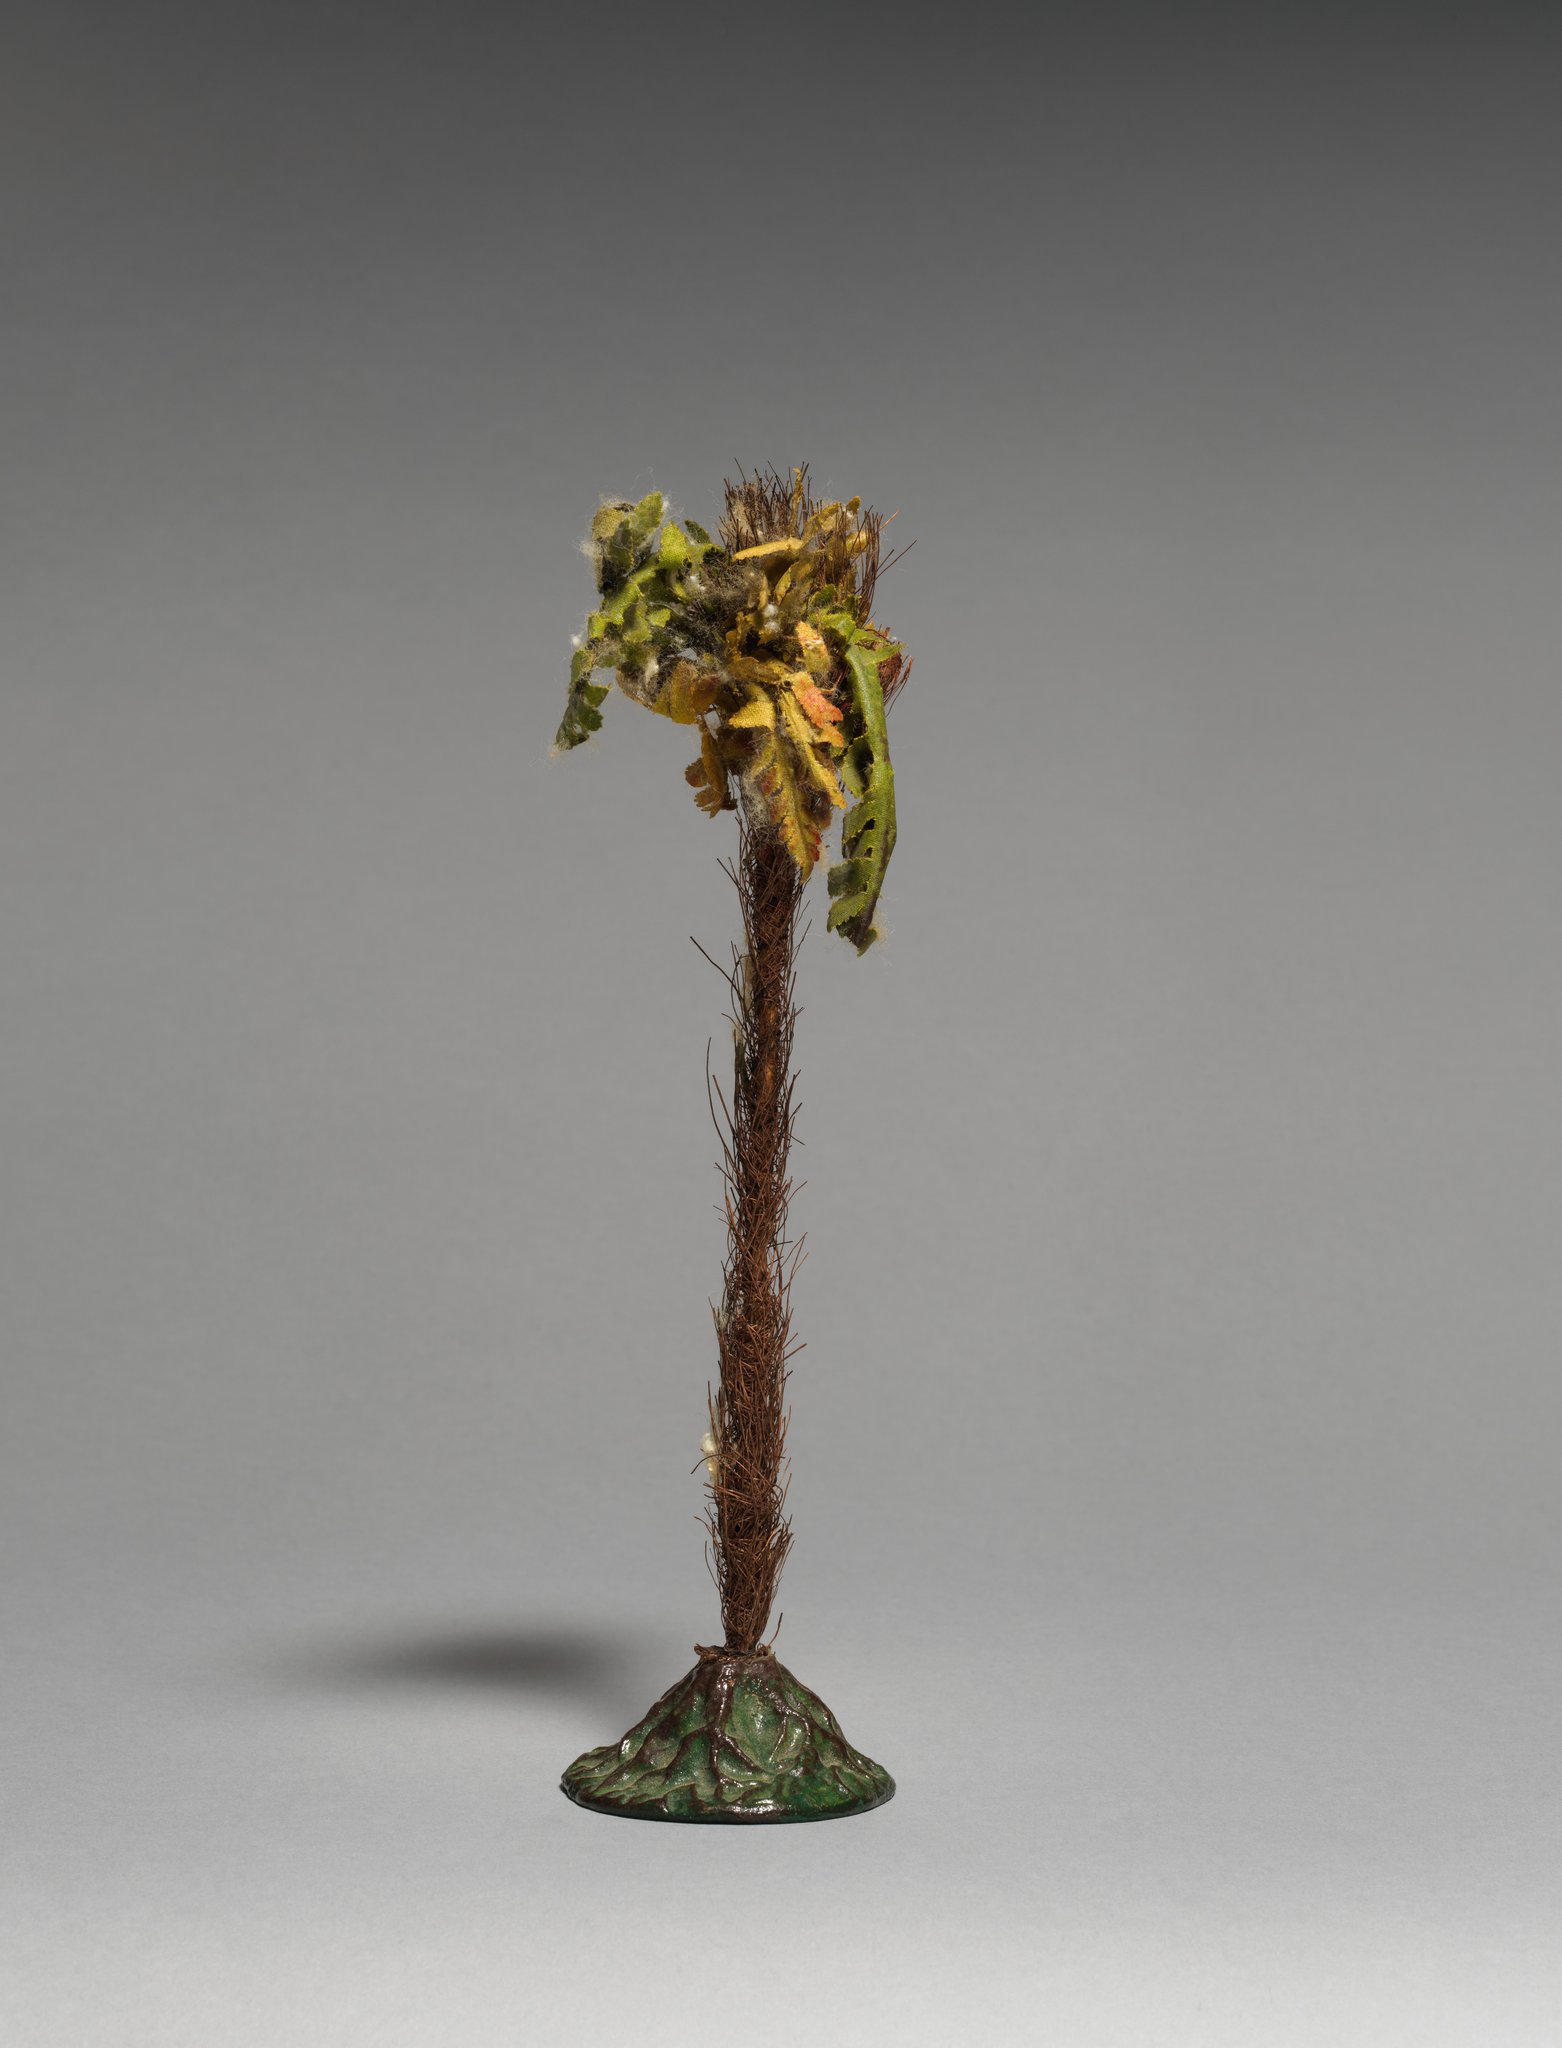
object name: crèche accessory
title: Tree (crèche accessory)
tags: trees